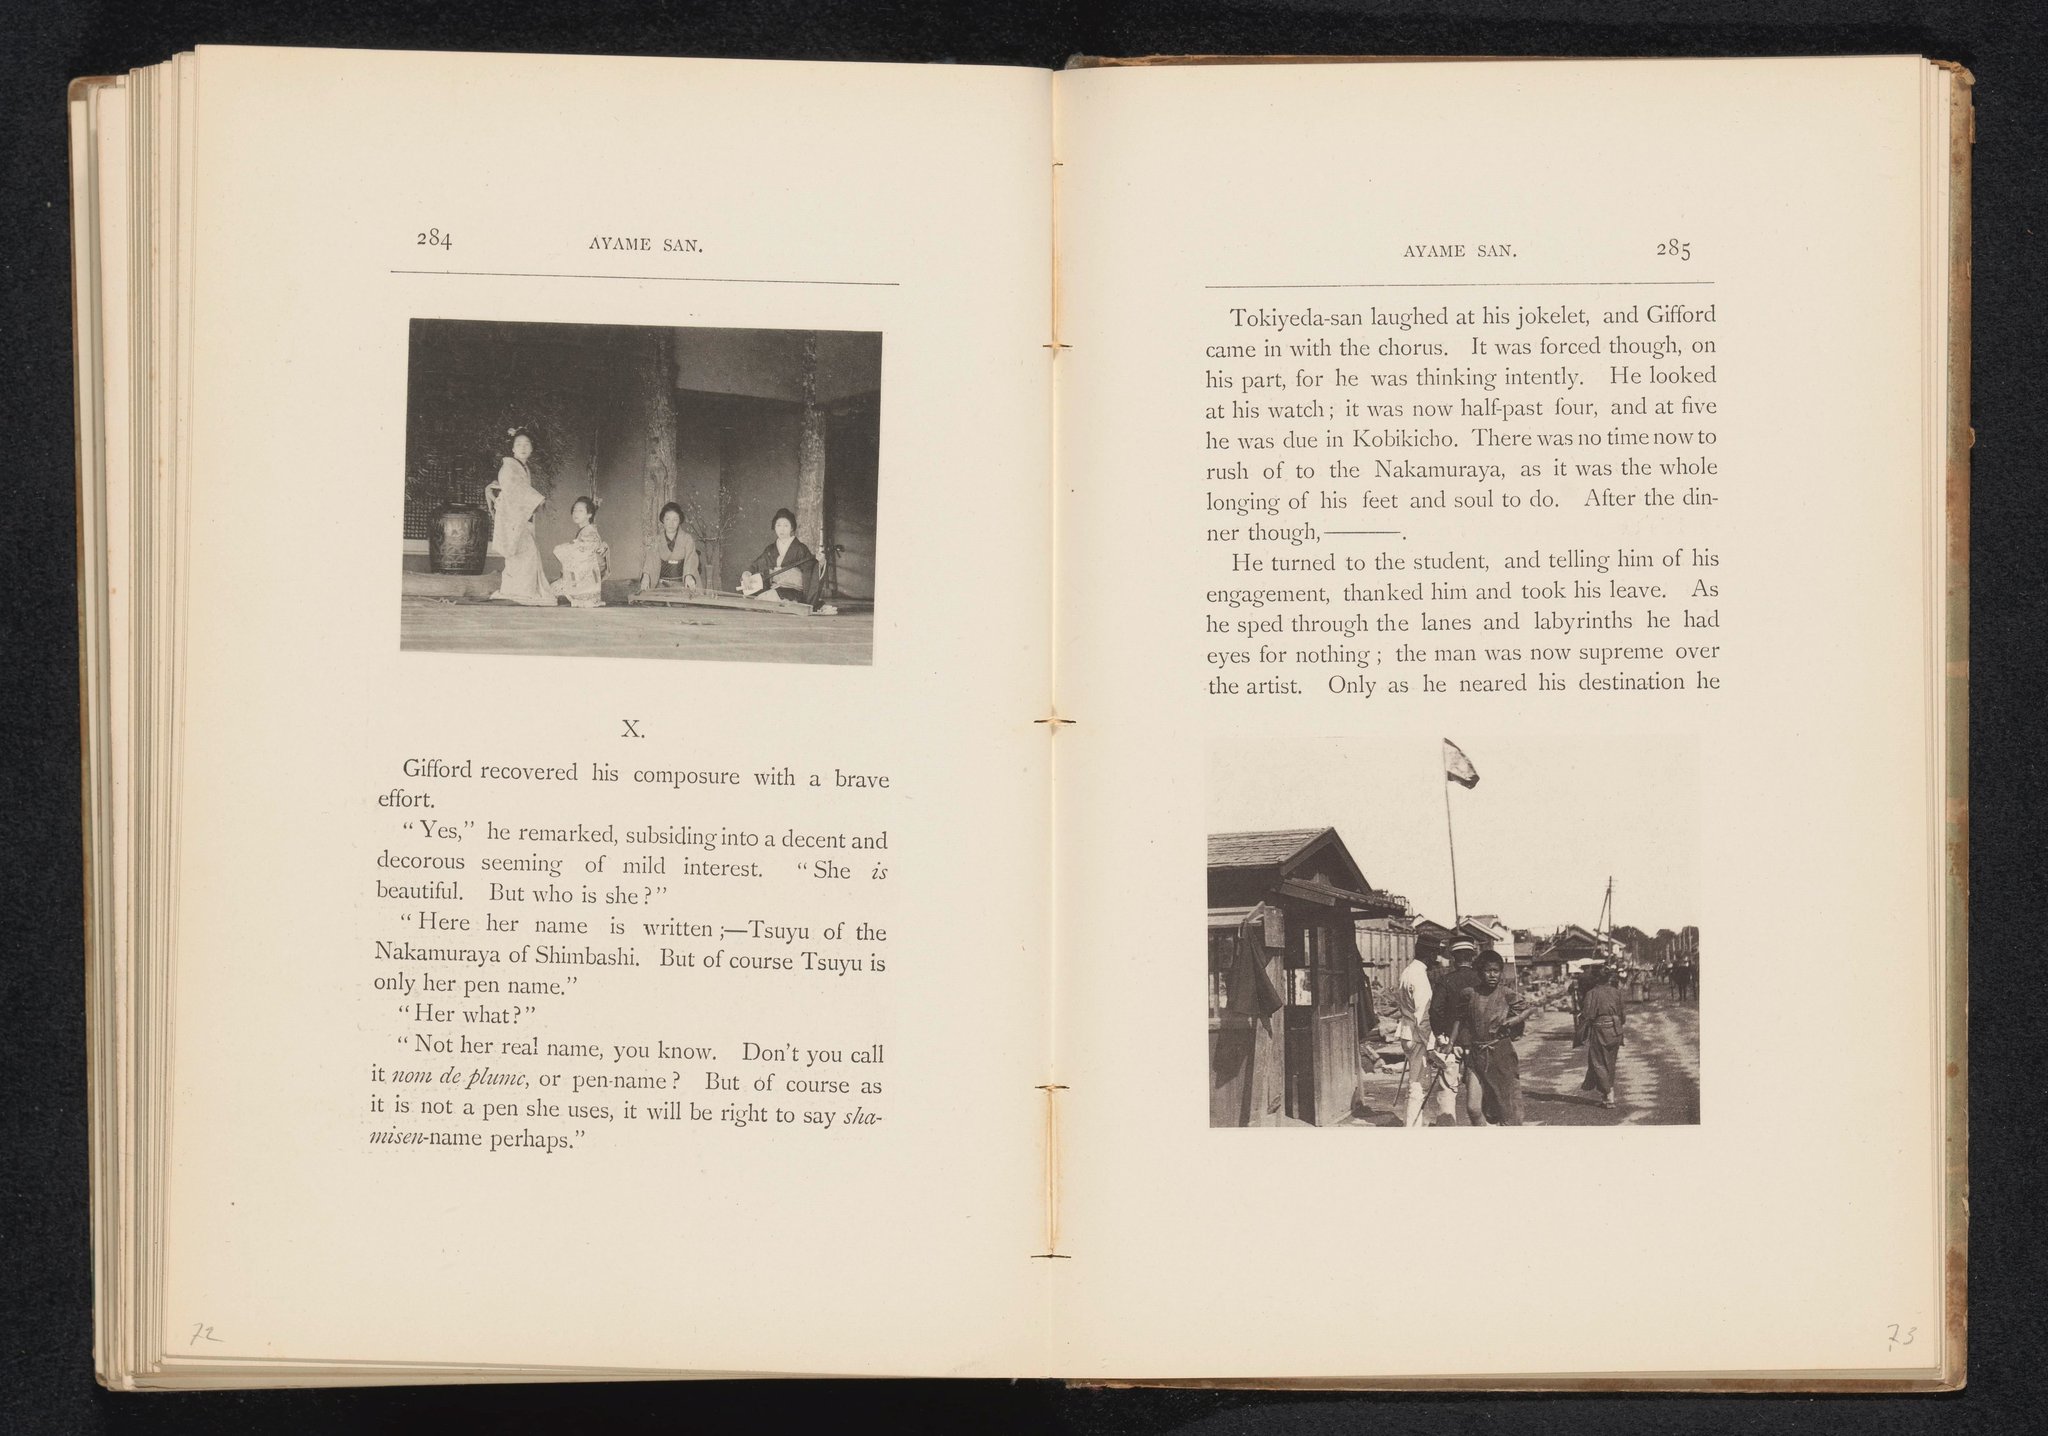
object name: photomechanical print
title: Gezicht op een straat te Japan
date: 1882-1892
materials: paper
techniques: photograph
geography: japan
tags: street